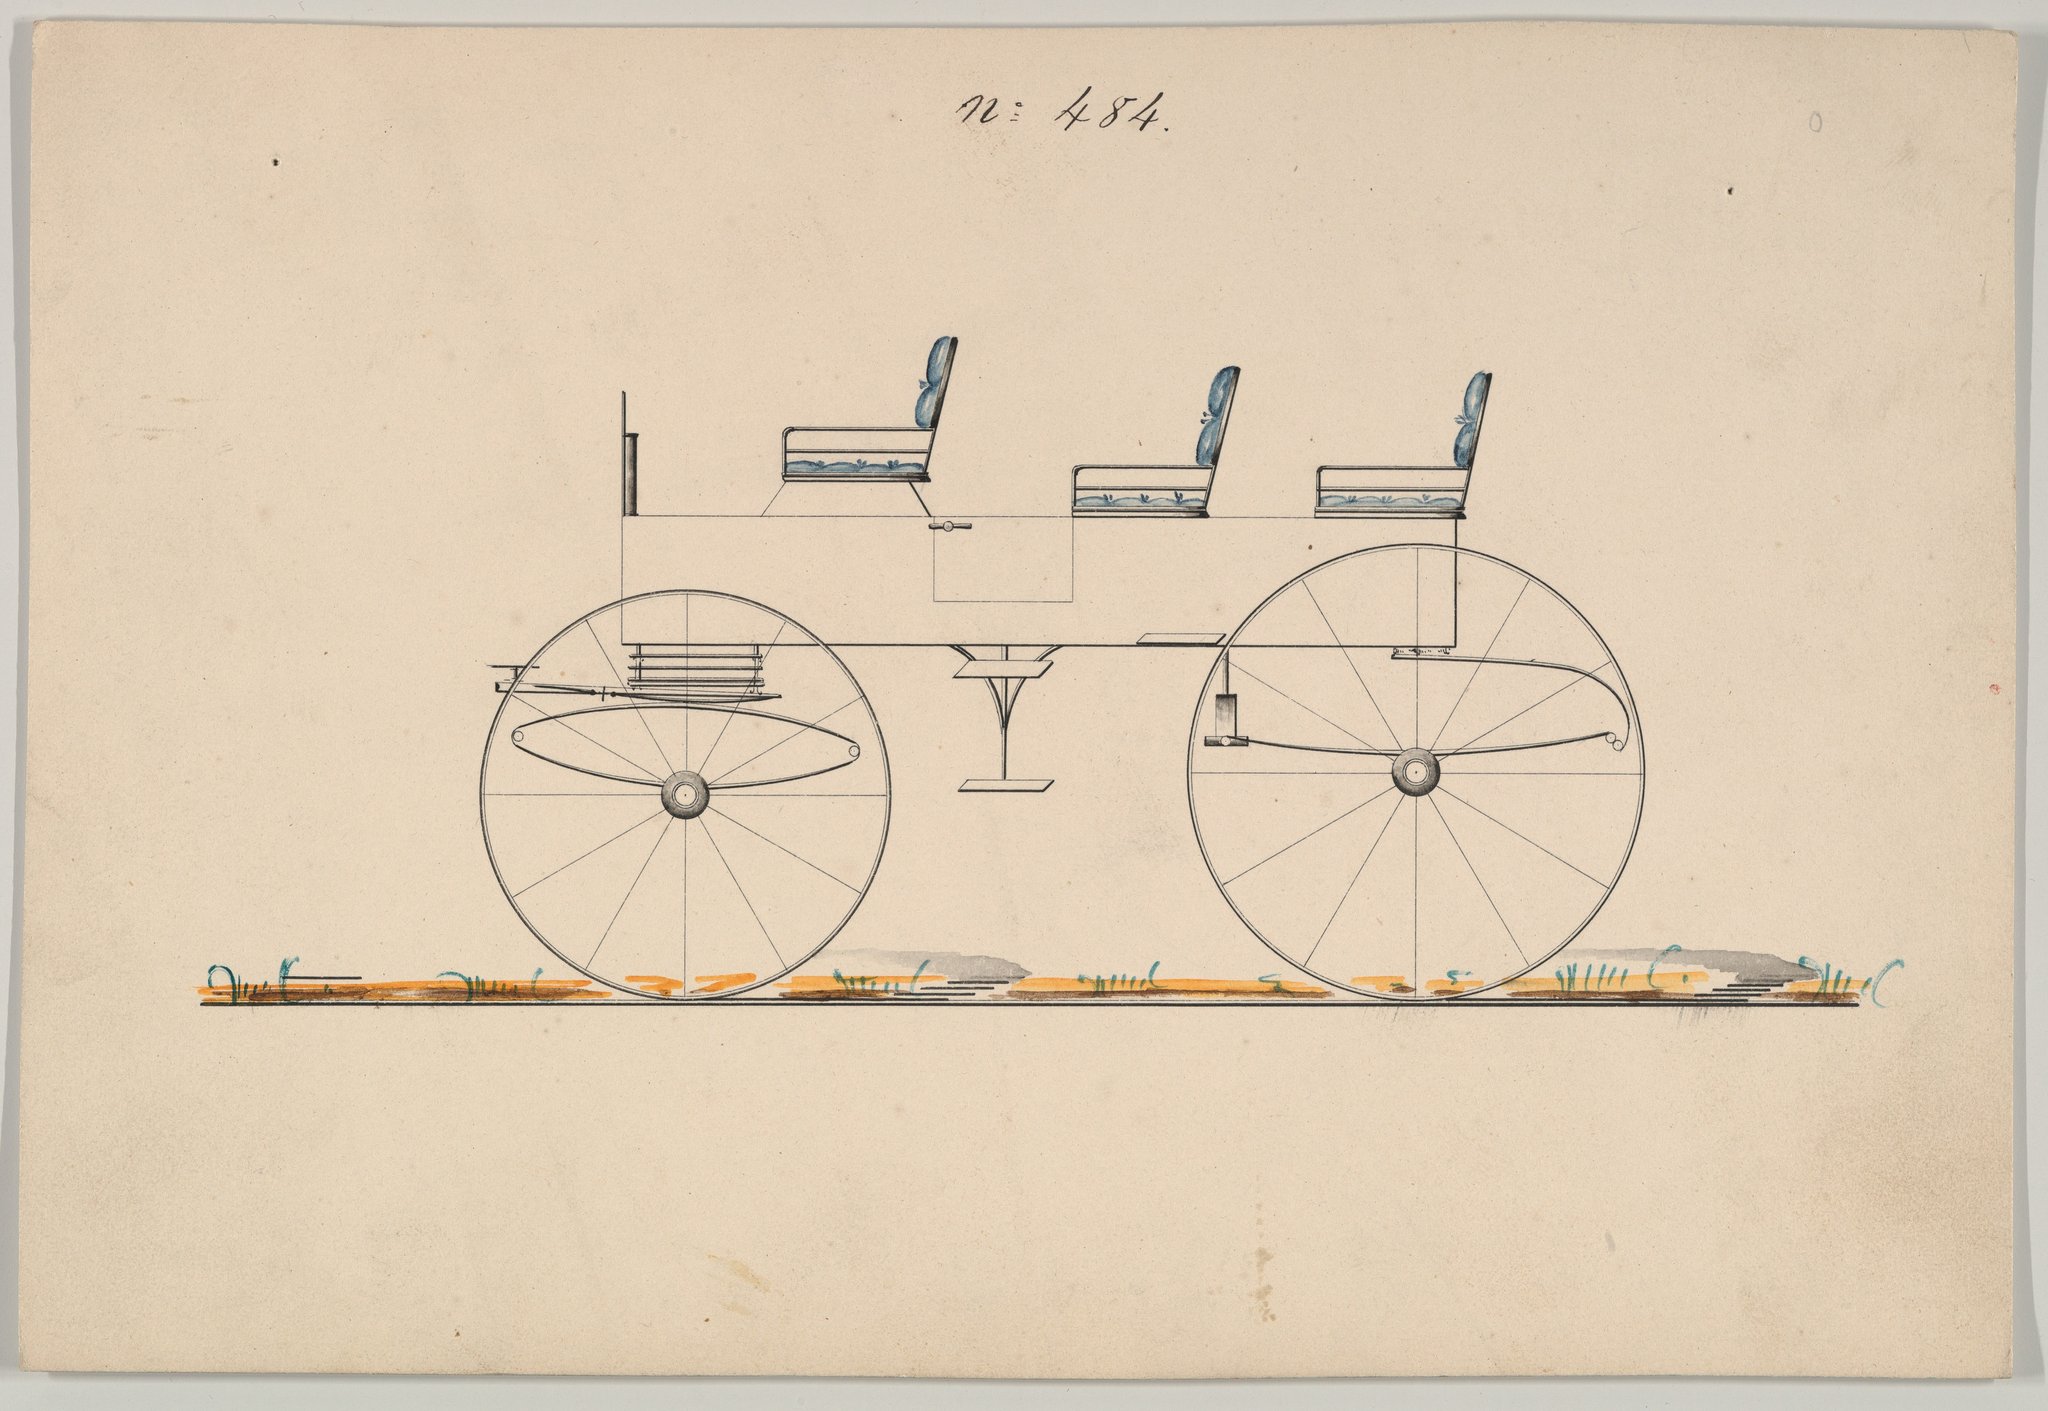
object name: drawing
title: Design for Wagon, no. 484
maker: brewster & co.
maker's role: manufacturer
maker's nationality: american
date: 1850-1870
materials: gouache, ink, watercolor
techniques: pen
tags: carriages